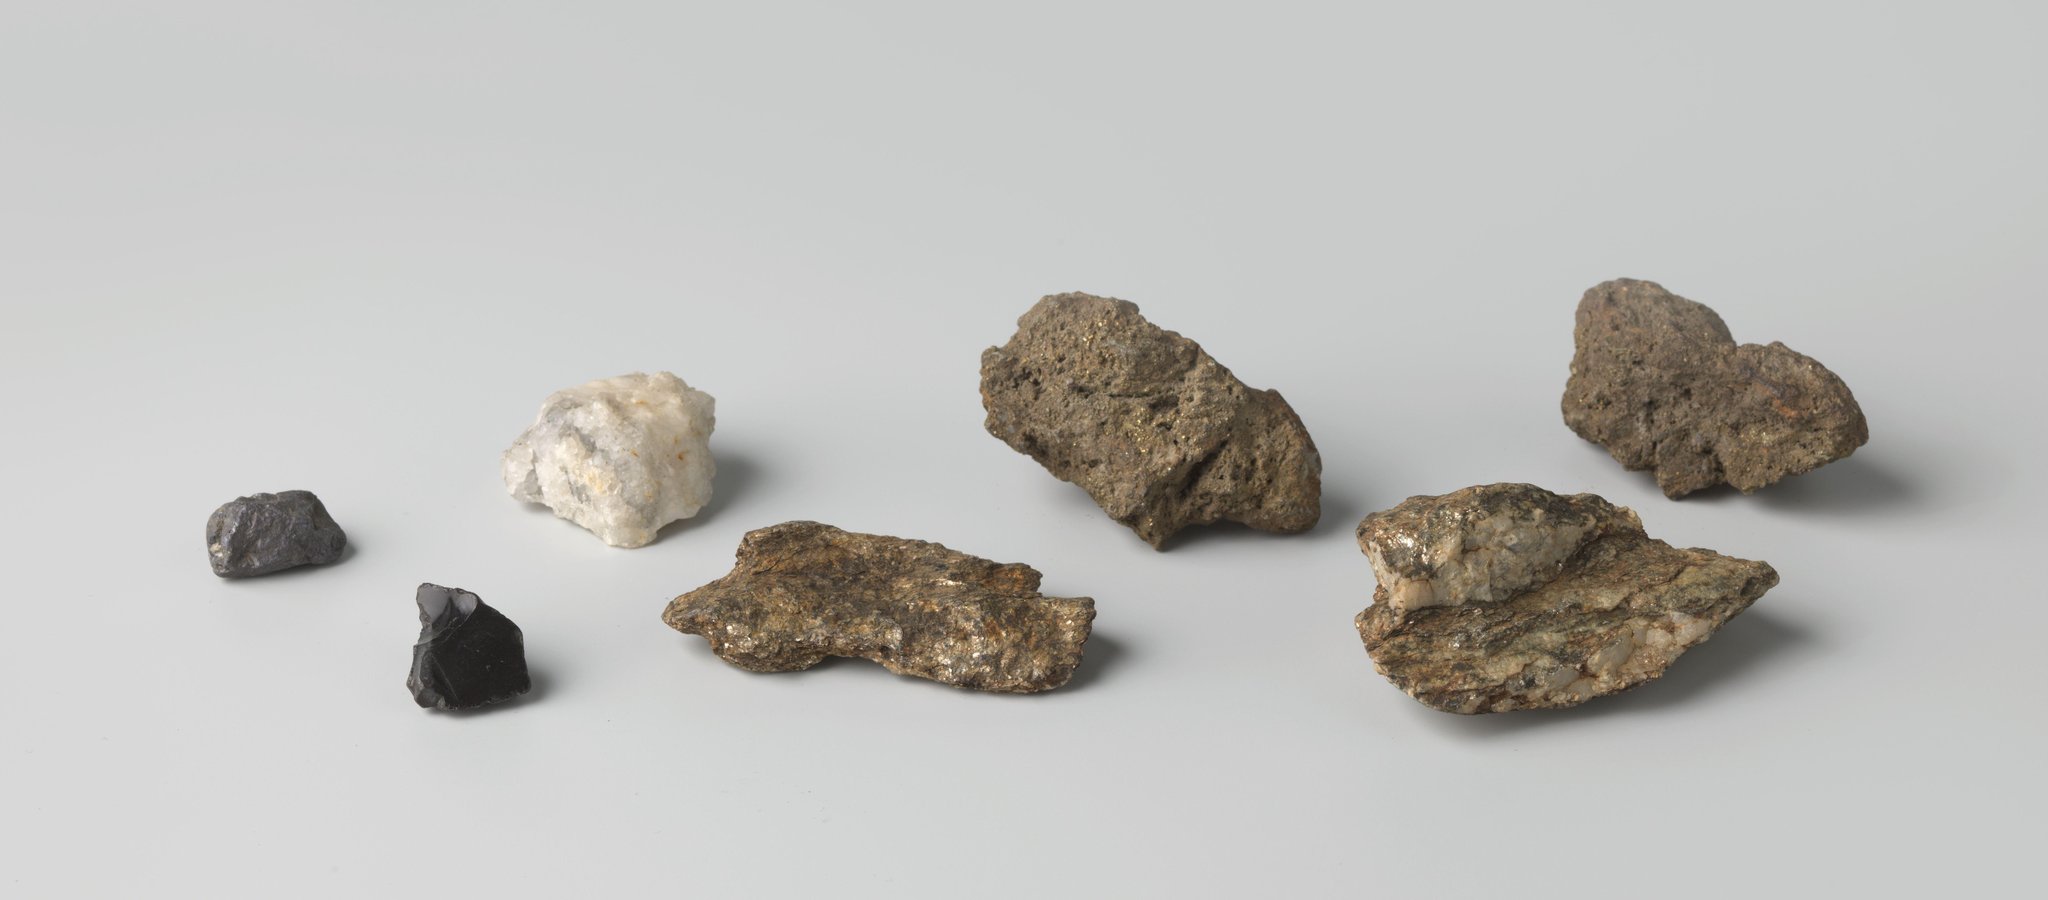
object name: pebble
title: Zeven kiezelstenen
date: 1400-1950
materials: stone